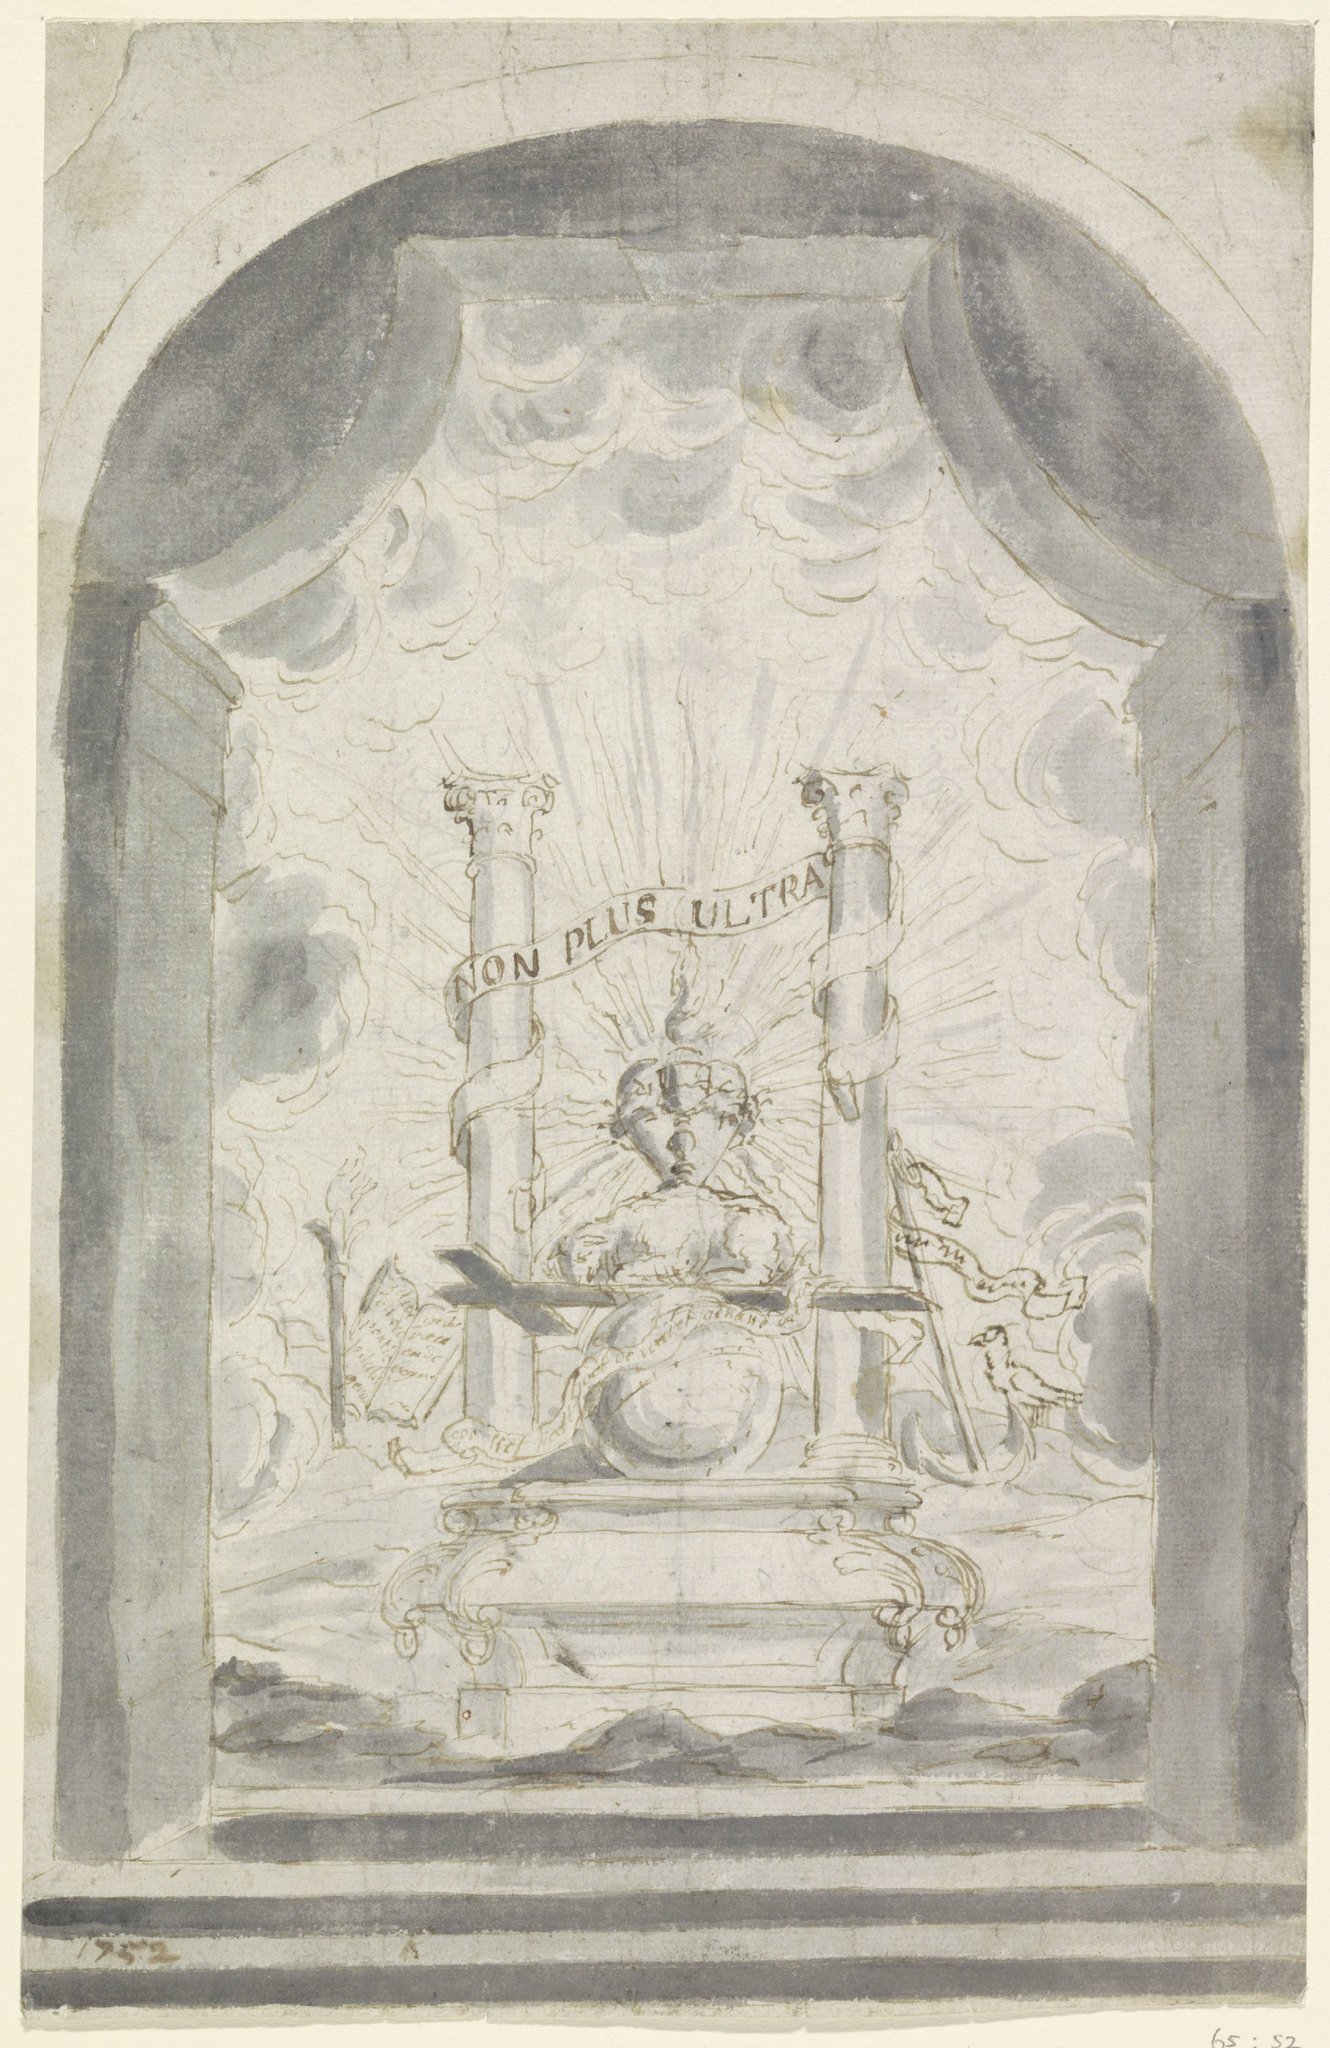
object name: ornamenttekening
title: Brandend hart en lam met kruis tussen zuilen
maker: Anonymous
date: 1752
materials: ink, paper, pencil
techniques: brush, pen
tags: lamb bearing cross or banner, 'agnus dei' ~ symbol of christ, column, pillar ~ architecture, the sacred heart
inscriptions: inscription: ‘Het lam met het Cruys moet daar nyt blijven’, collector's mark: Lugt 2228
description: Het brandend hart, het lam met het kruis en een globe met banderol tussen twee zuilen met de spreuk Non Plus Ultra. Links een fakkel en een boek. Rechts een anker, banderol en duif.